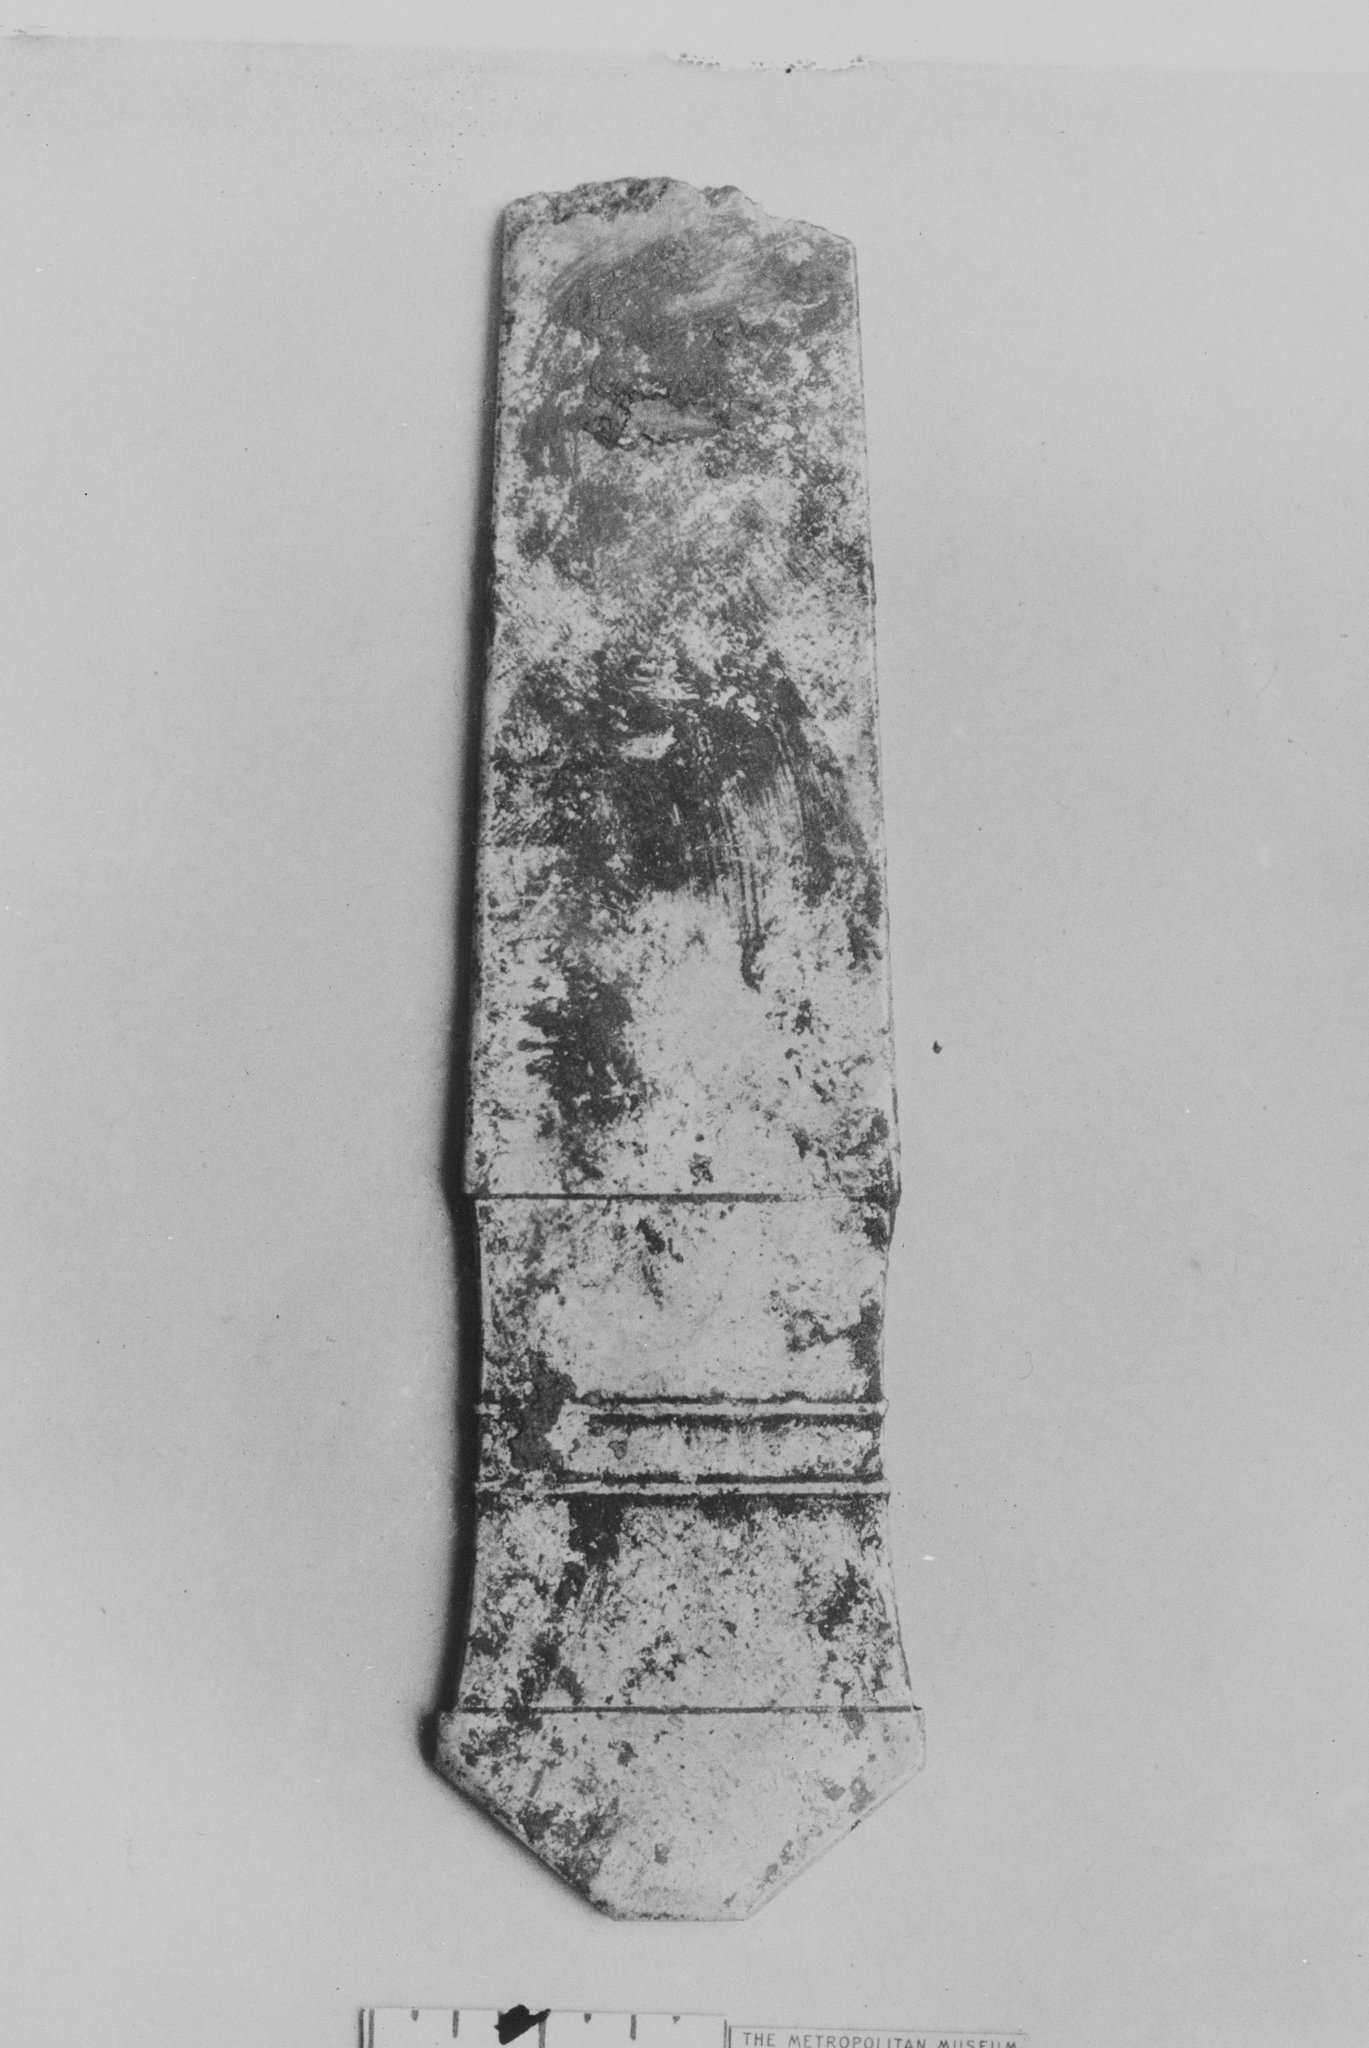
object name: handle shaped object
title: Handle-shaped object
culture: chinese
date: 1046-256 BCE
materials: jade